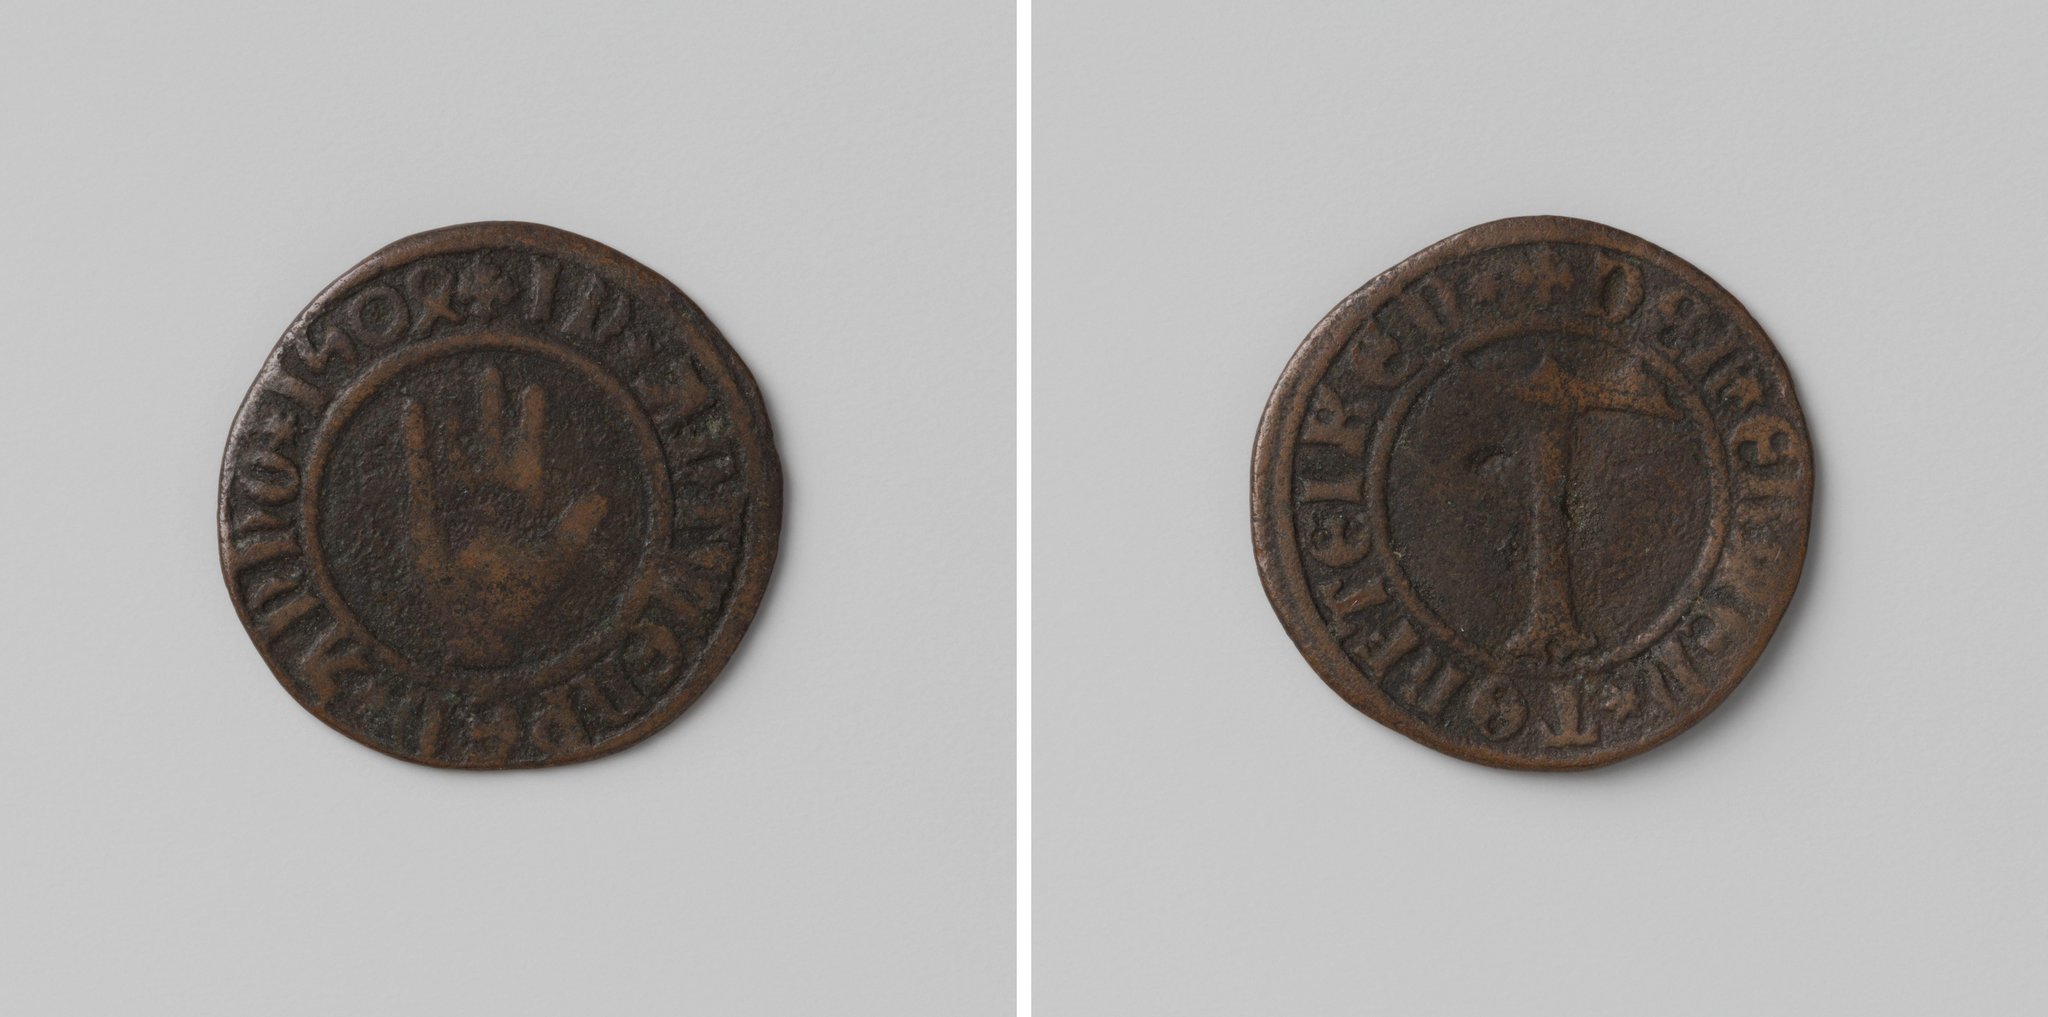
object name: armenloodje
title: Stad Antwerpen, loodje dat bij uitdeling recht gaf op turf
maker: Anonymous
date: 1504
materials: copper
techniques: striking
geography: antwerp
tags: antwerp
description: Koperen penning. Voorzijde: geopende hand binnen omschrift. Keerzijde: letter T binnen omschrift